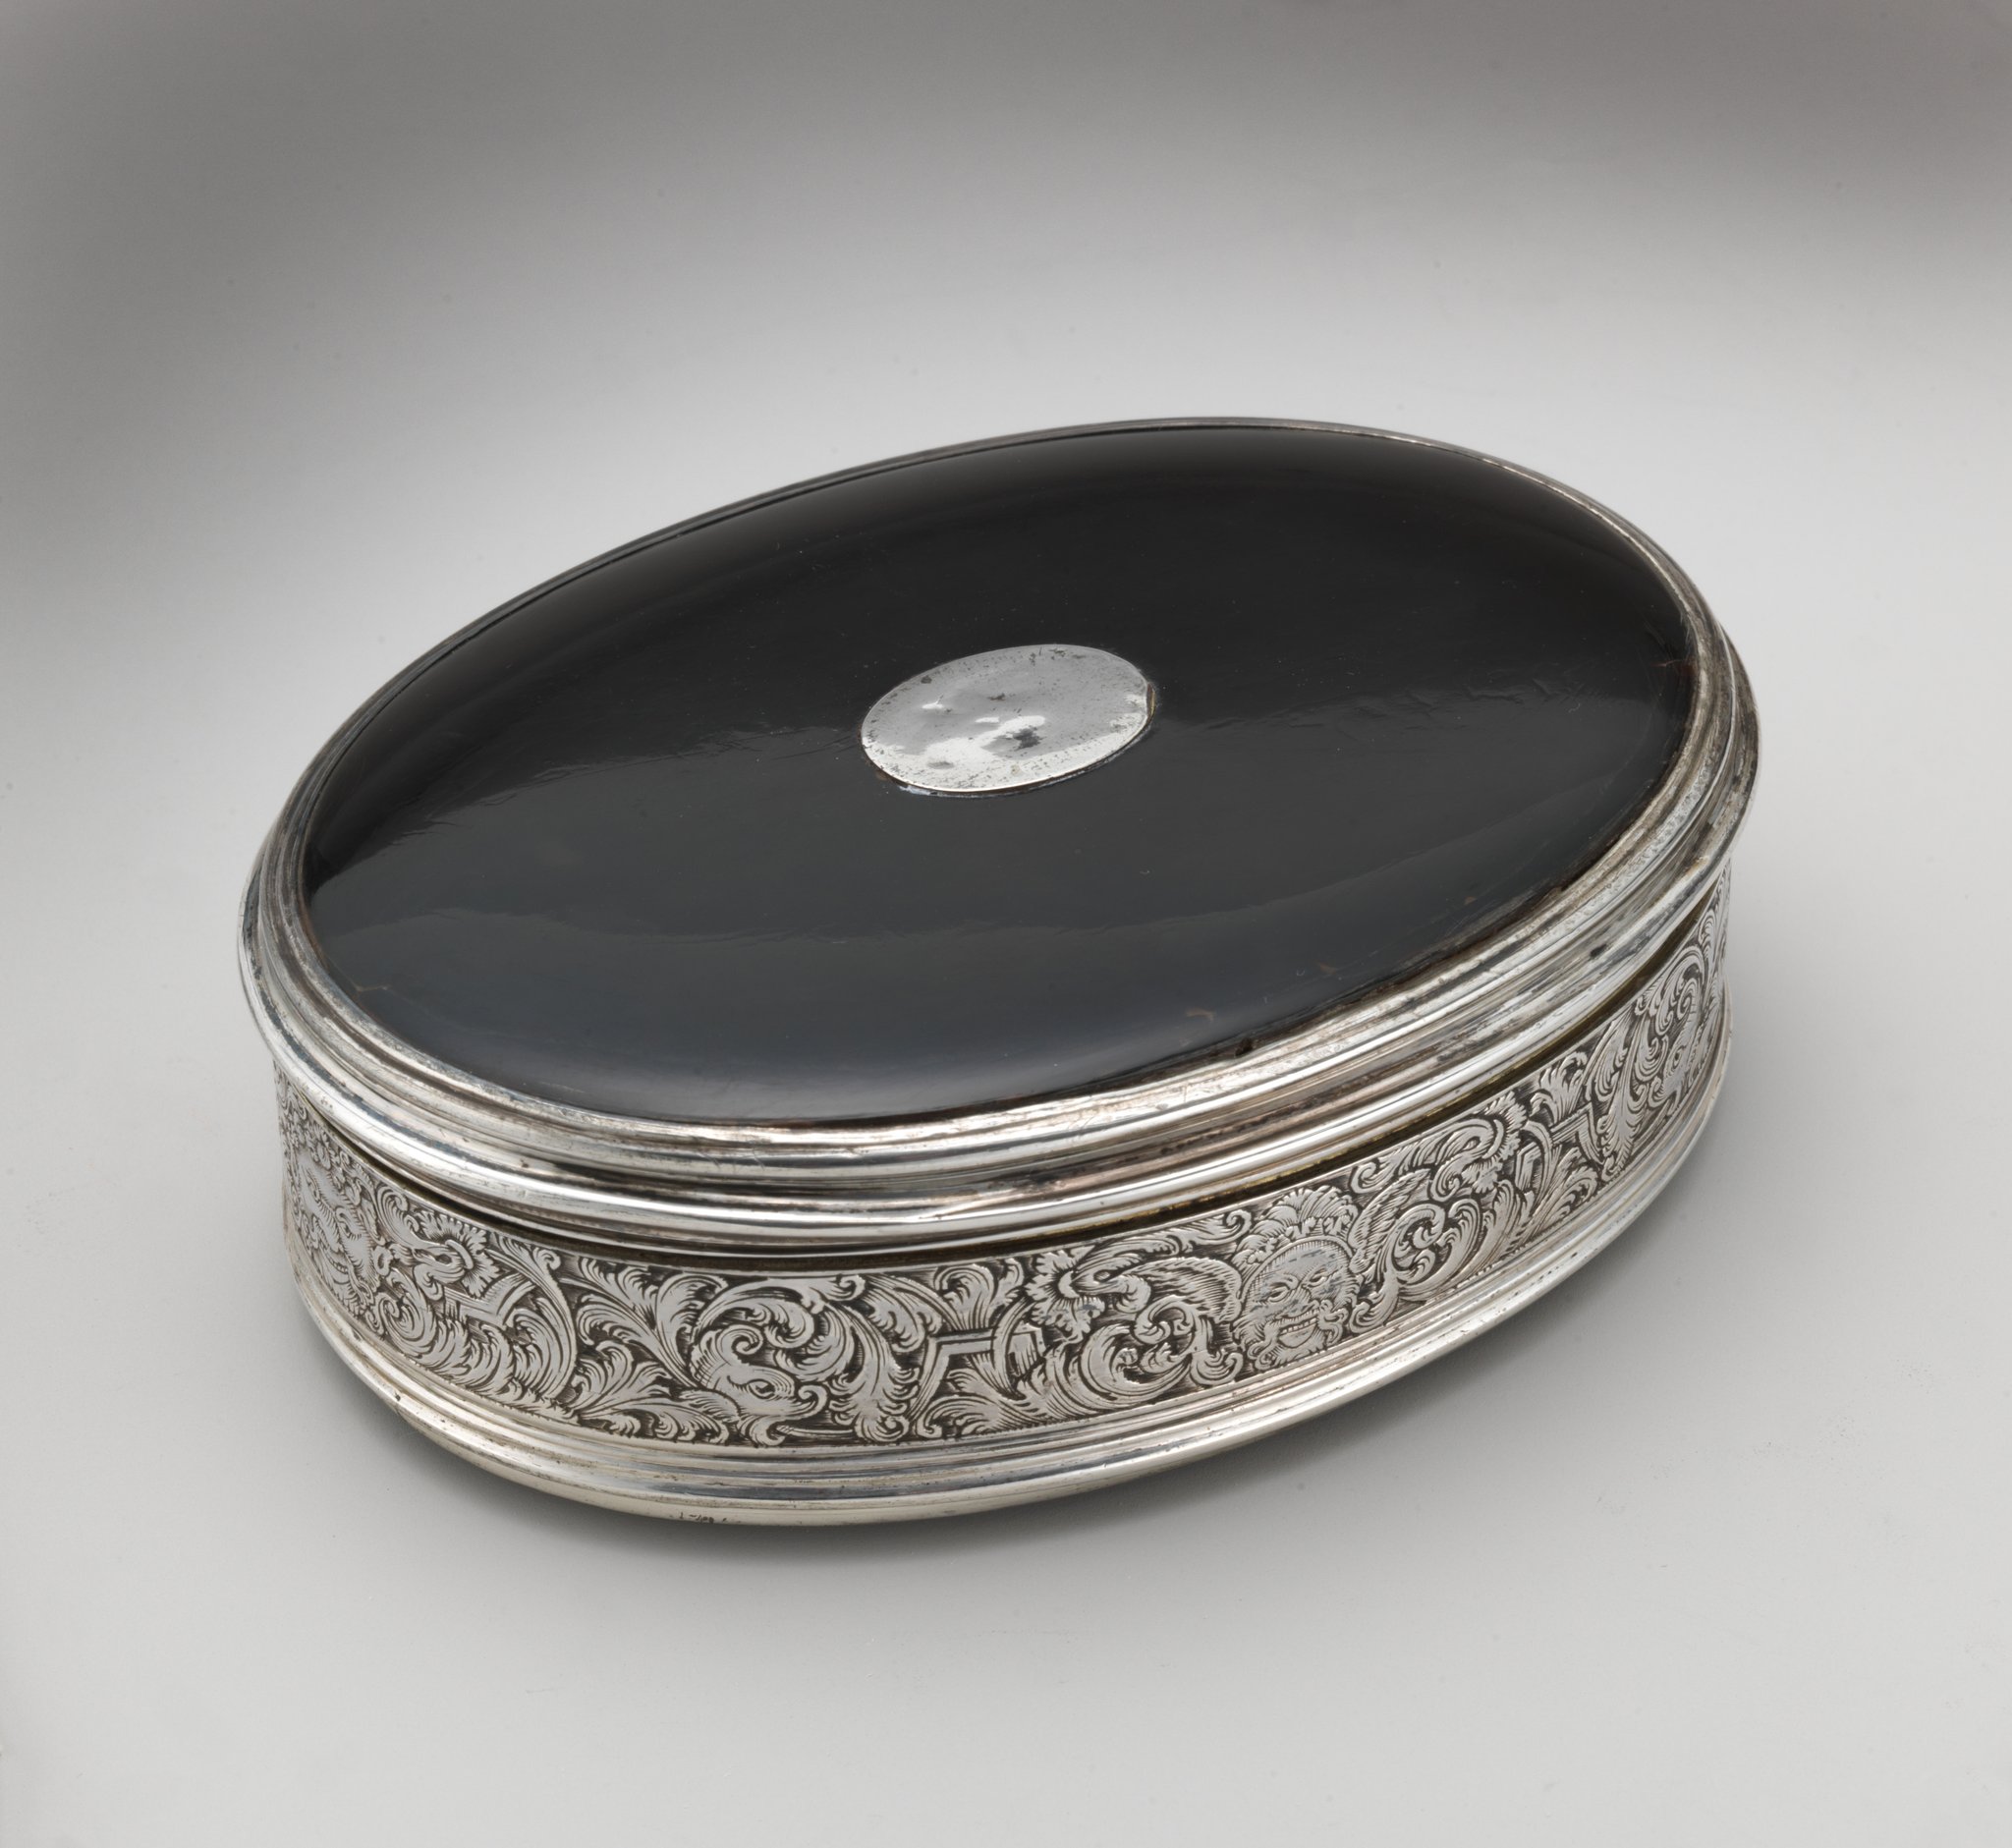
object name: box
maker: john lacy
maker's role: maker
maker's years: 1775-1875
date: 1832-1833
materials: silver, shell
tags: lions,leaves